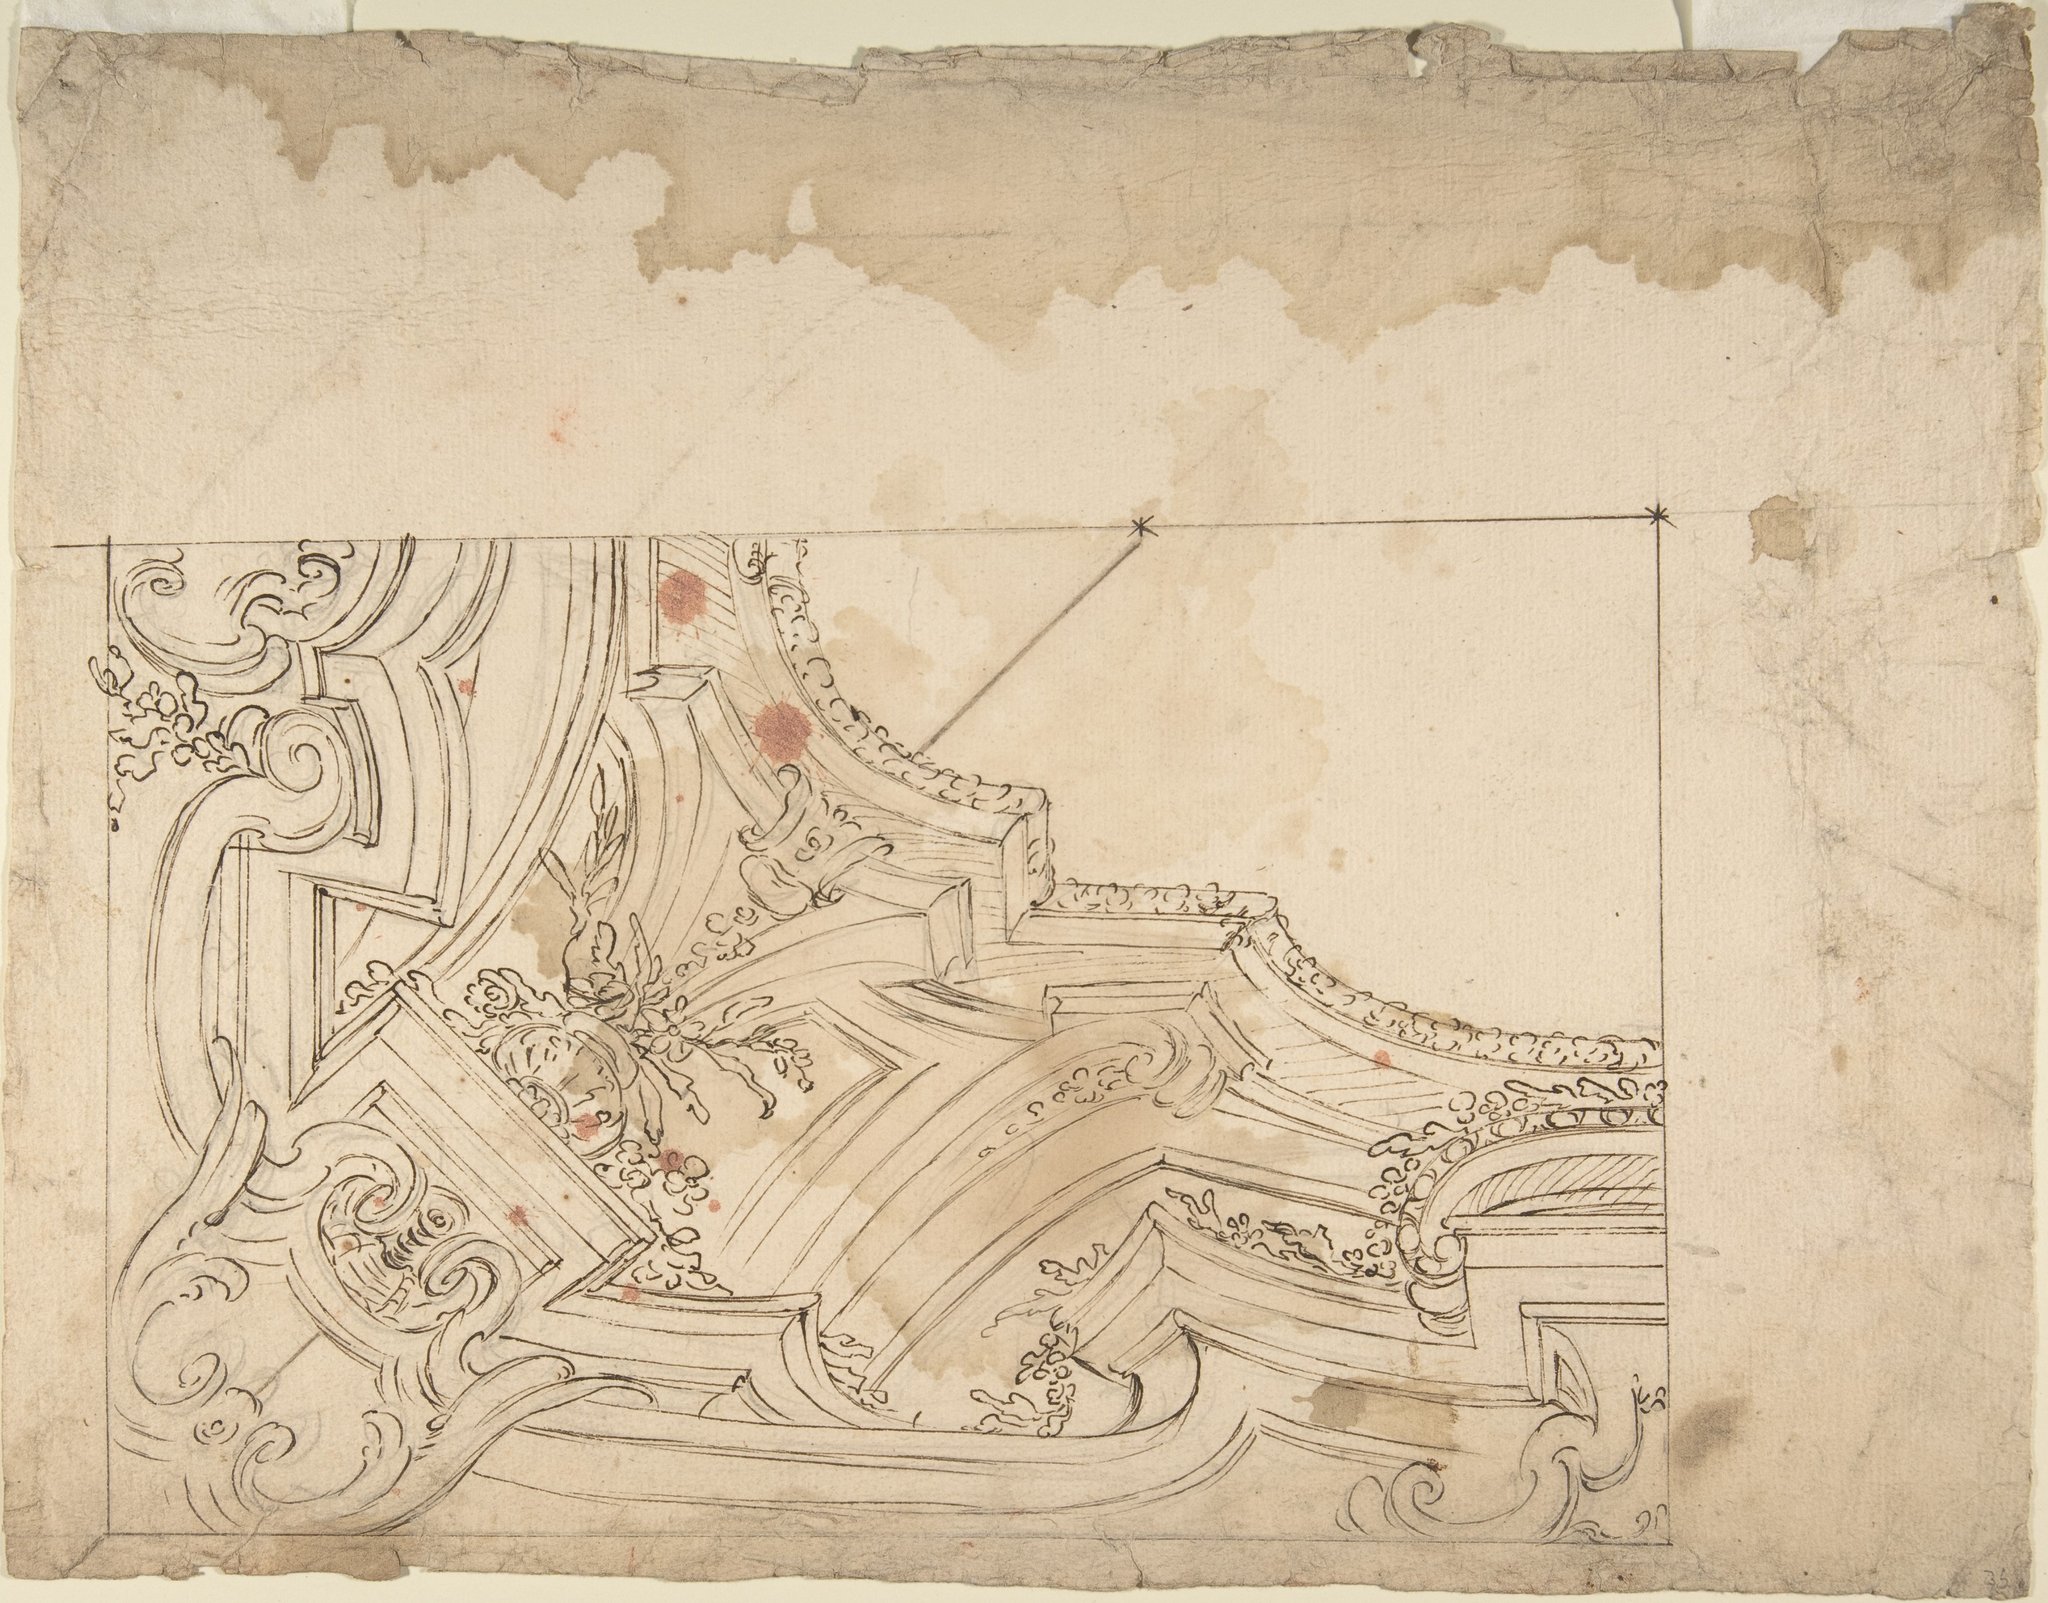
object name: drawing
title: Design for Corner of a Cove (recto); Designs for a Ceiling (?) (verso)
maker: anonymous, italian, piedmontese, 18th century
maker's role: artist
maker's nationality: italian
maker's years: 1700-1800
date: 1700-1780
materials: graphite, ink, lead, drawing material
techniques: pen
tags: architecture